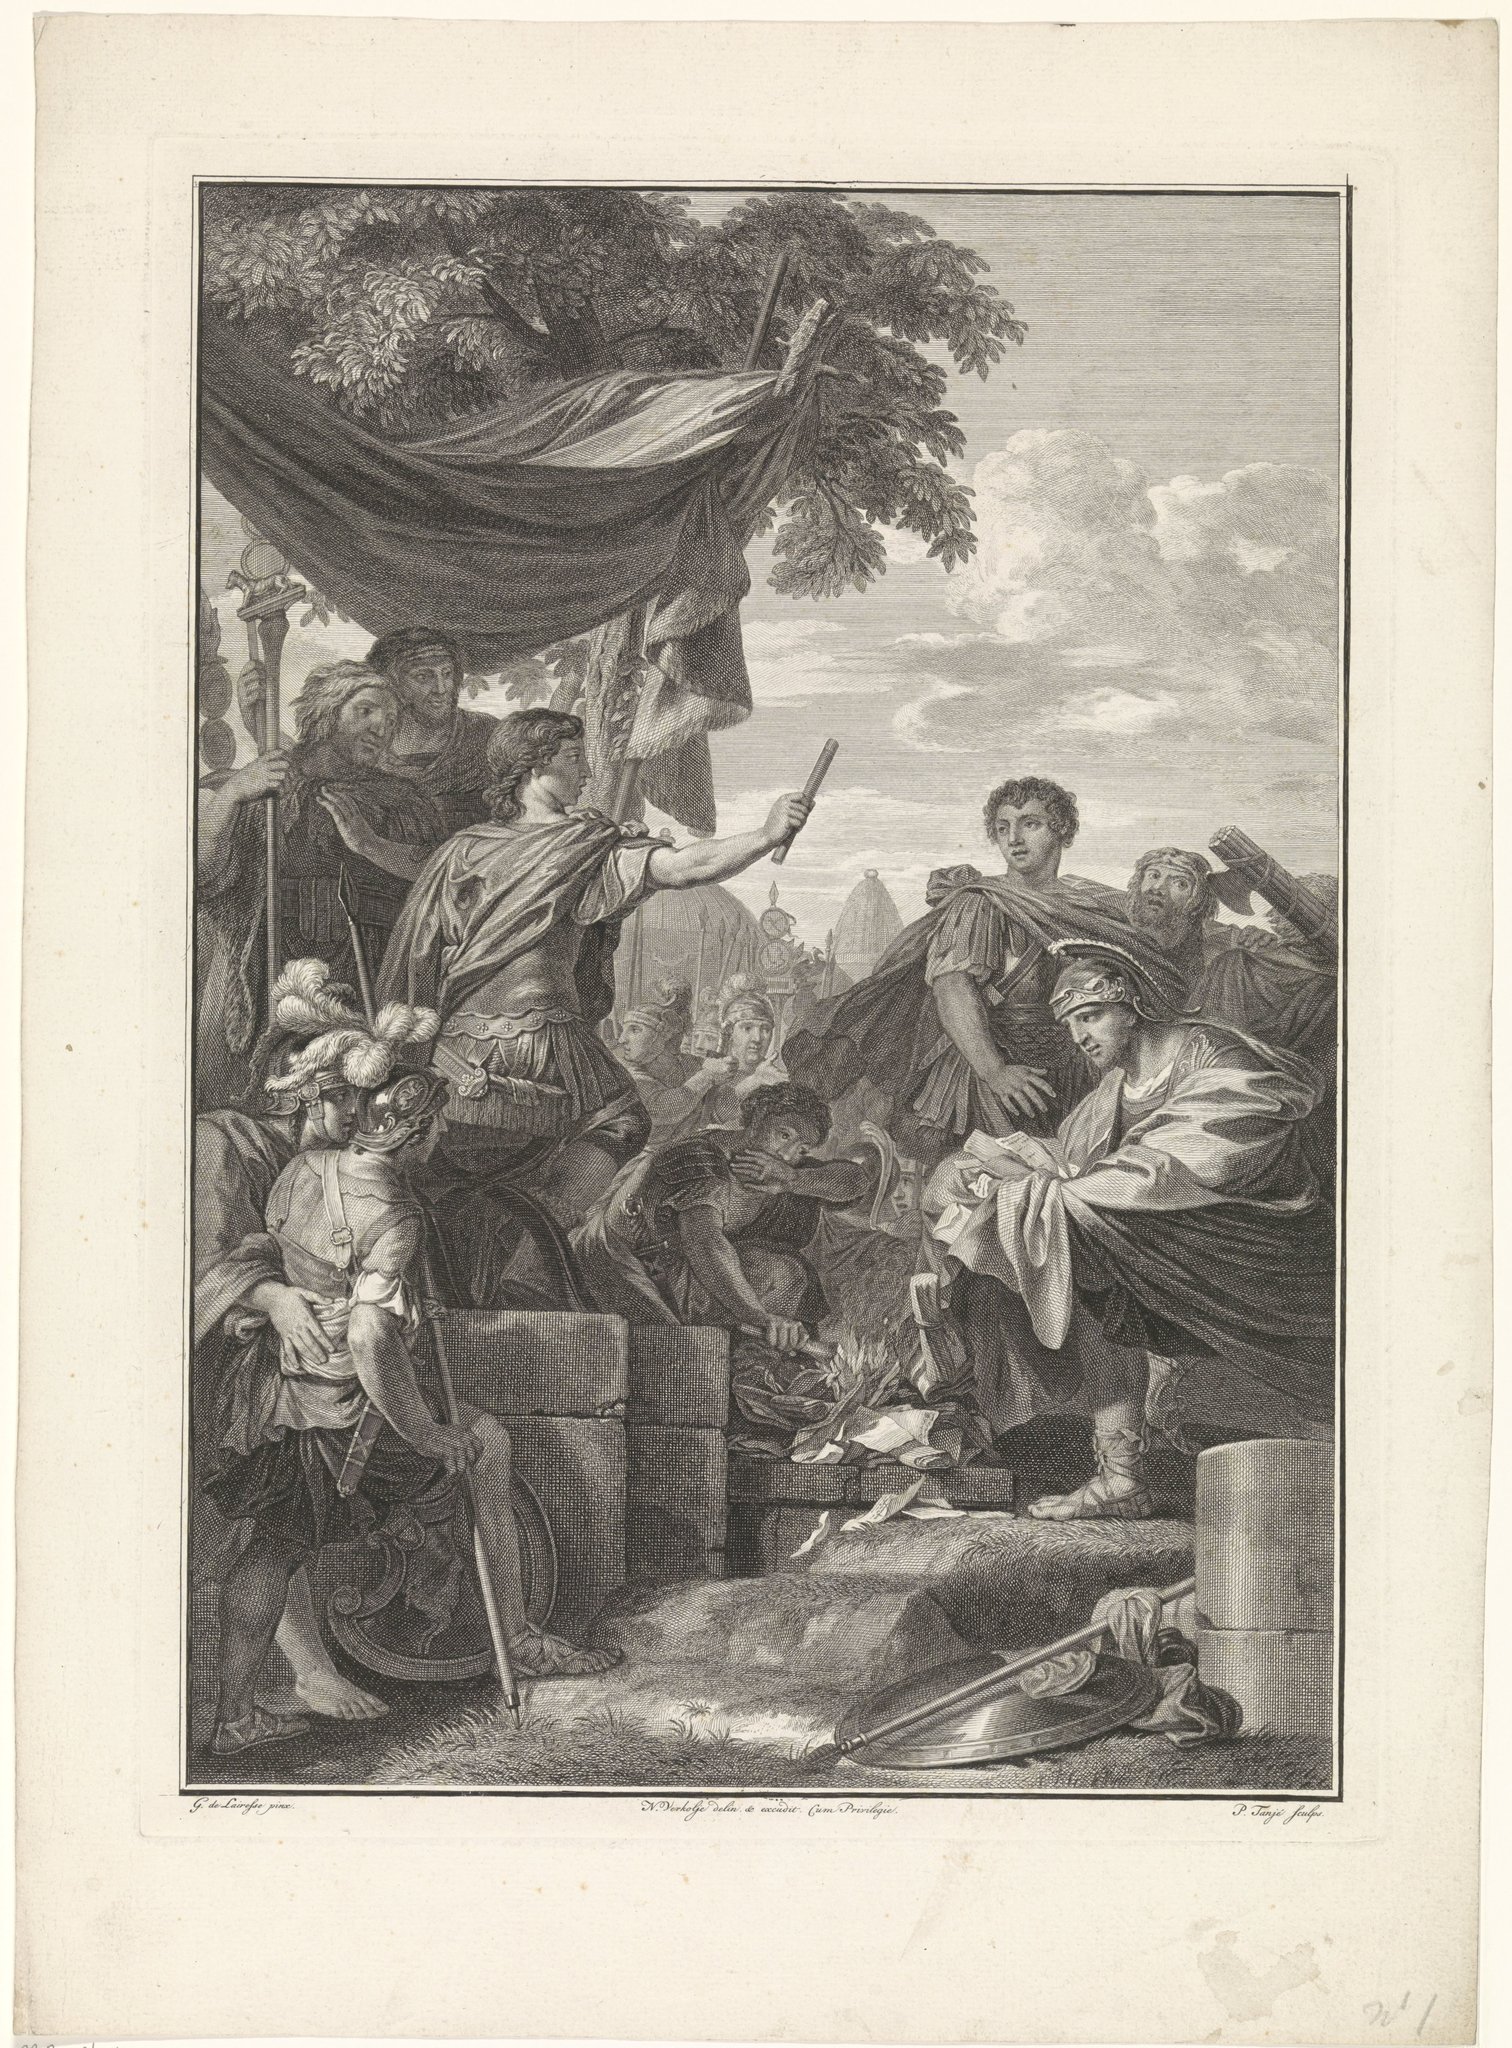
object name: print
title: Pompeius laat de brieven van Marcus Peperna verbranden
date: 1737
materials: paper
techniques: engraving, etching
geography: amsterdam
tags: (story of) sextus pompeius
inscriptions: collector's mark: Lugt 2228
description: Sextus Pompeius, met bevelhebberstaf in de hand, laat de brieven van Marcus Peperna verbranden. Naar het schilderij in de Raadkamer van het Hof van Justitie van Holland, Zeeland en West-Friesland op het Binnenhof te Den Haag.